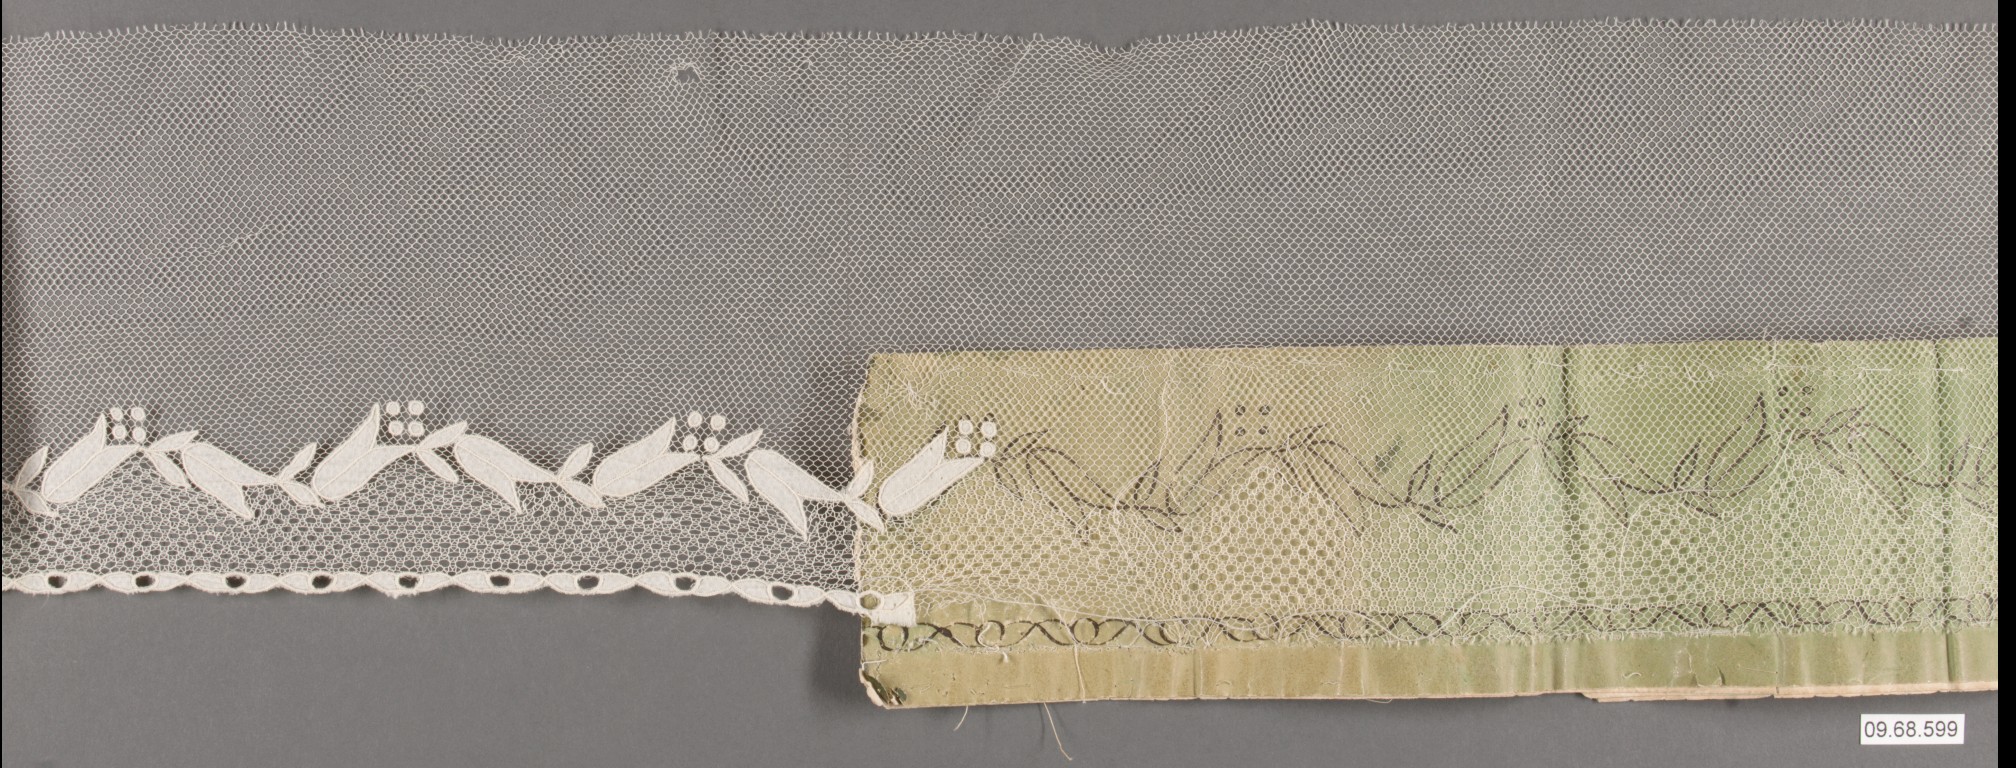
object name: appliqué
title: Applique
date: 1801-1900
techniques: lace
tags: flowers